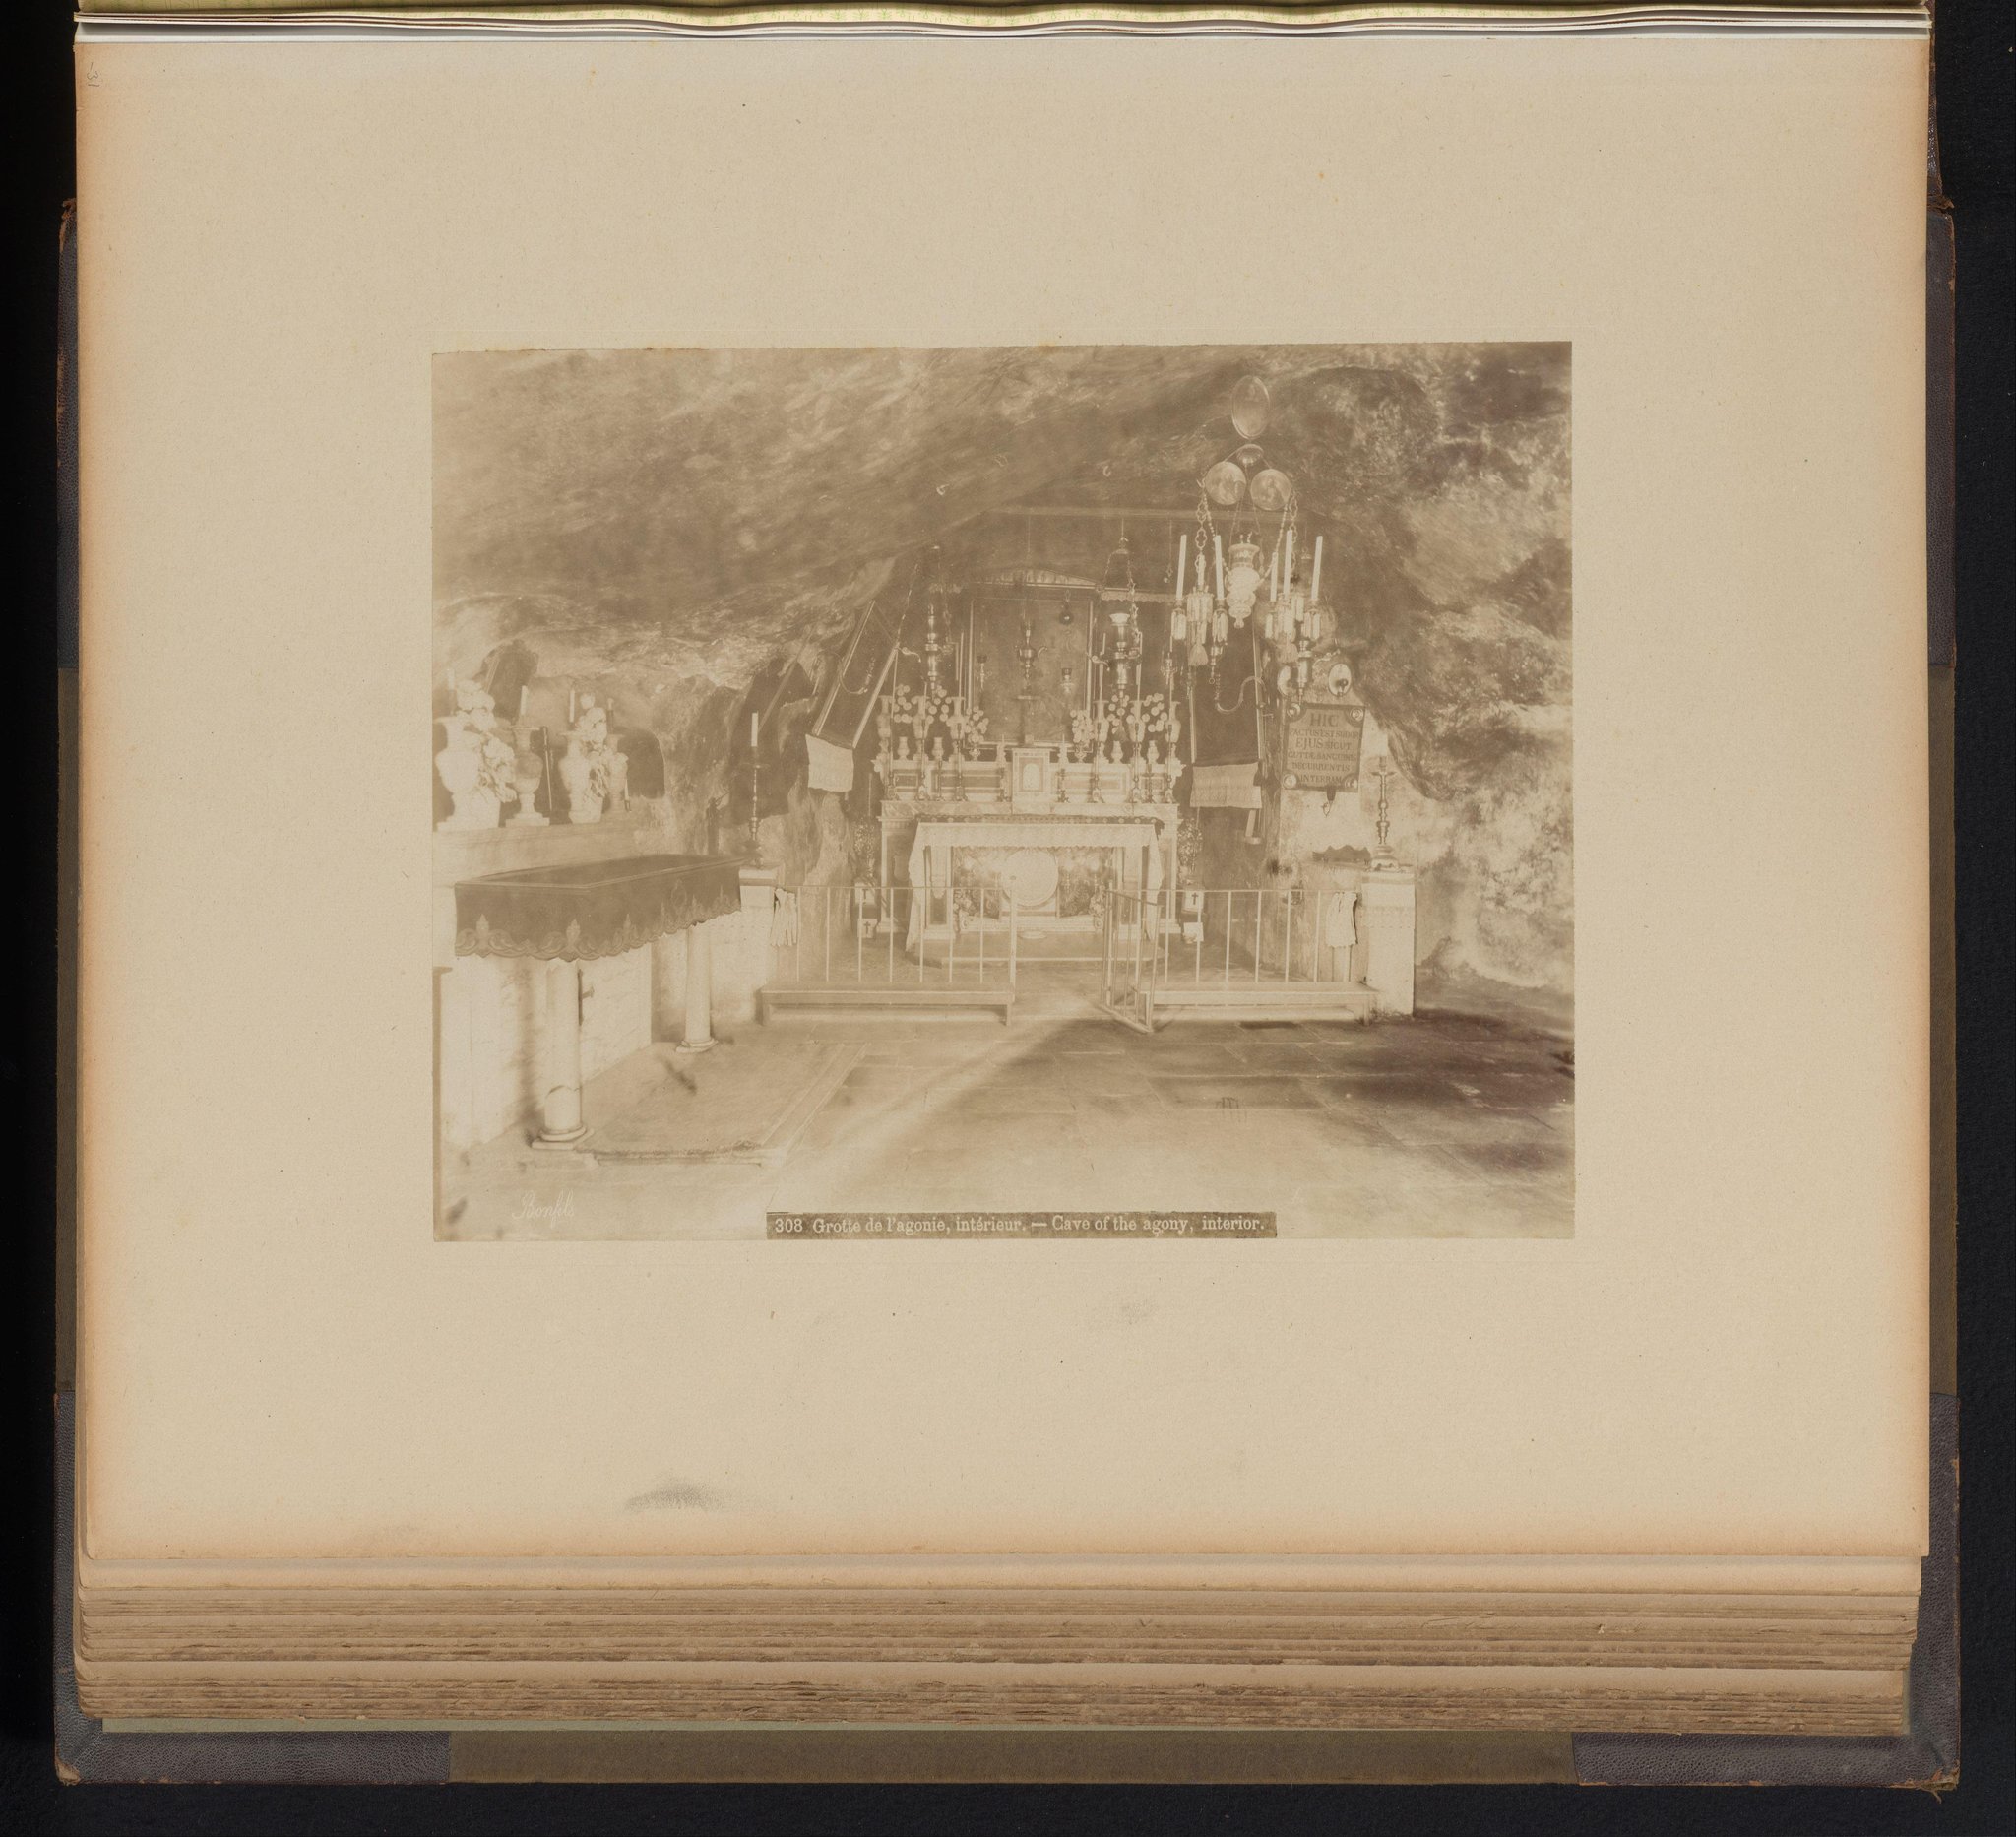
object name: photograph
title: Grotte de l'agonie, intérieur / Cave of the agony, interior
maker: félix bonfils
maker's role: fotograaf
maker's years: 1831-1885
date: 1867-1885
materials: paper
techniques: albumen print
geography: jerusalem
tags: altar with altar-piece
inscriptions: number: ‘308’